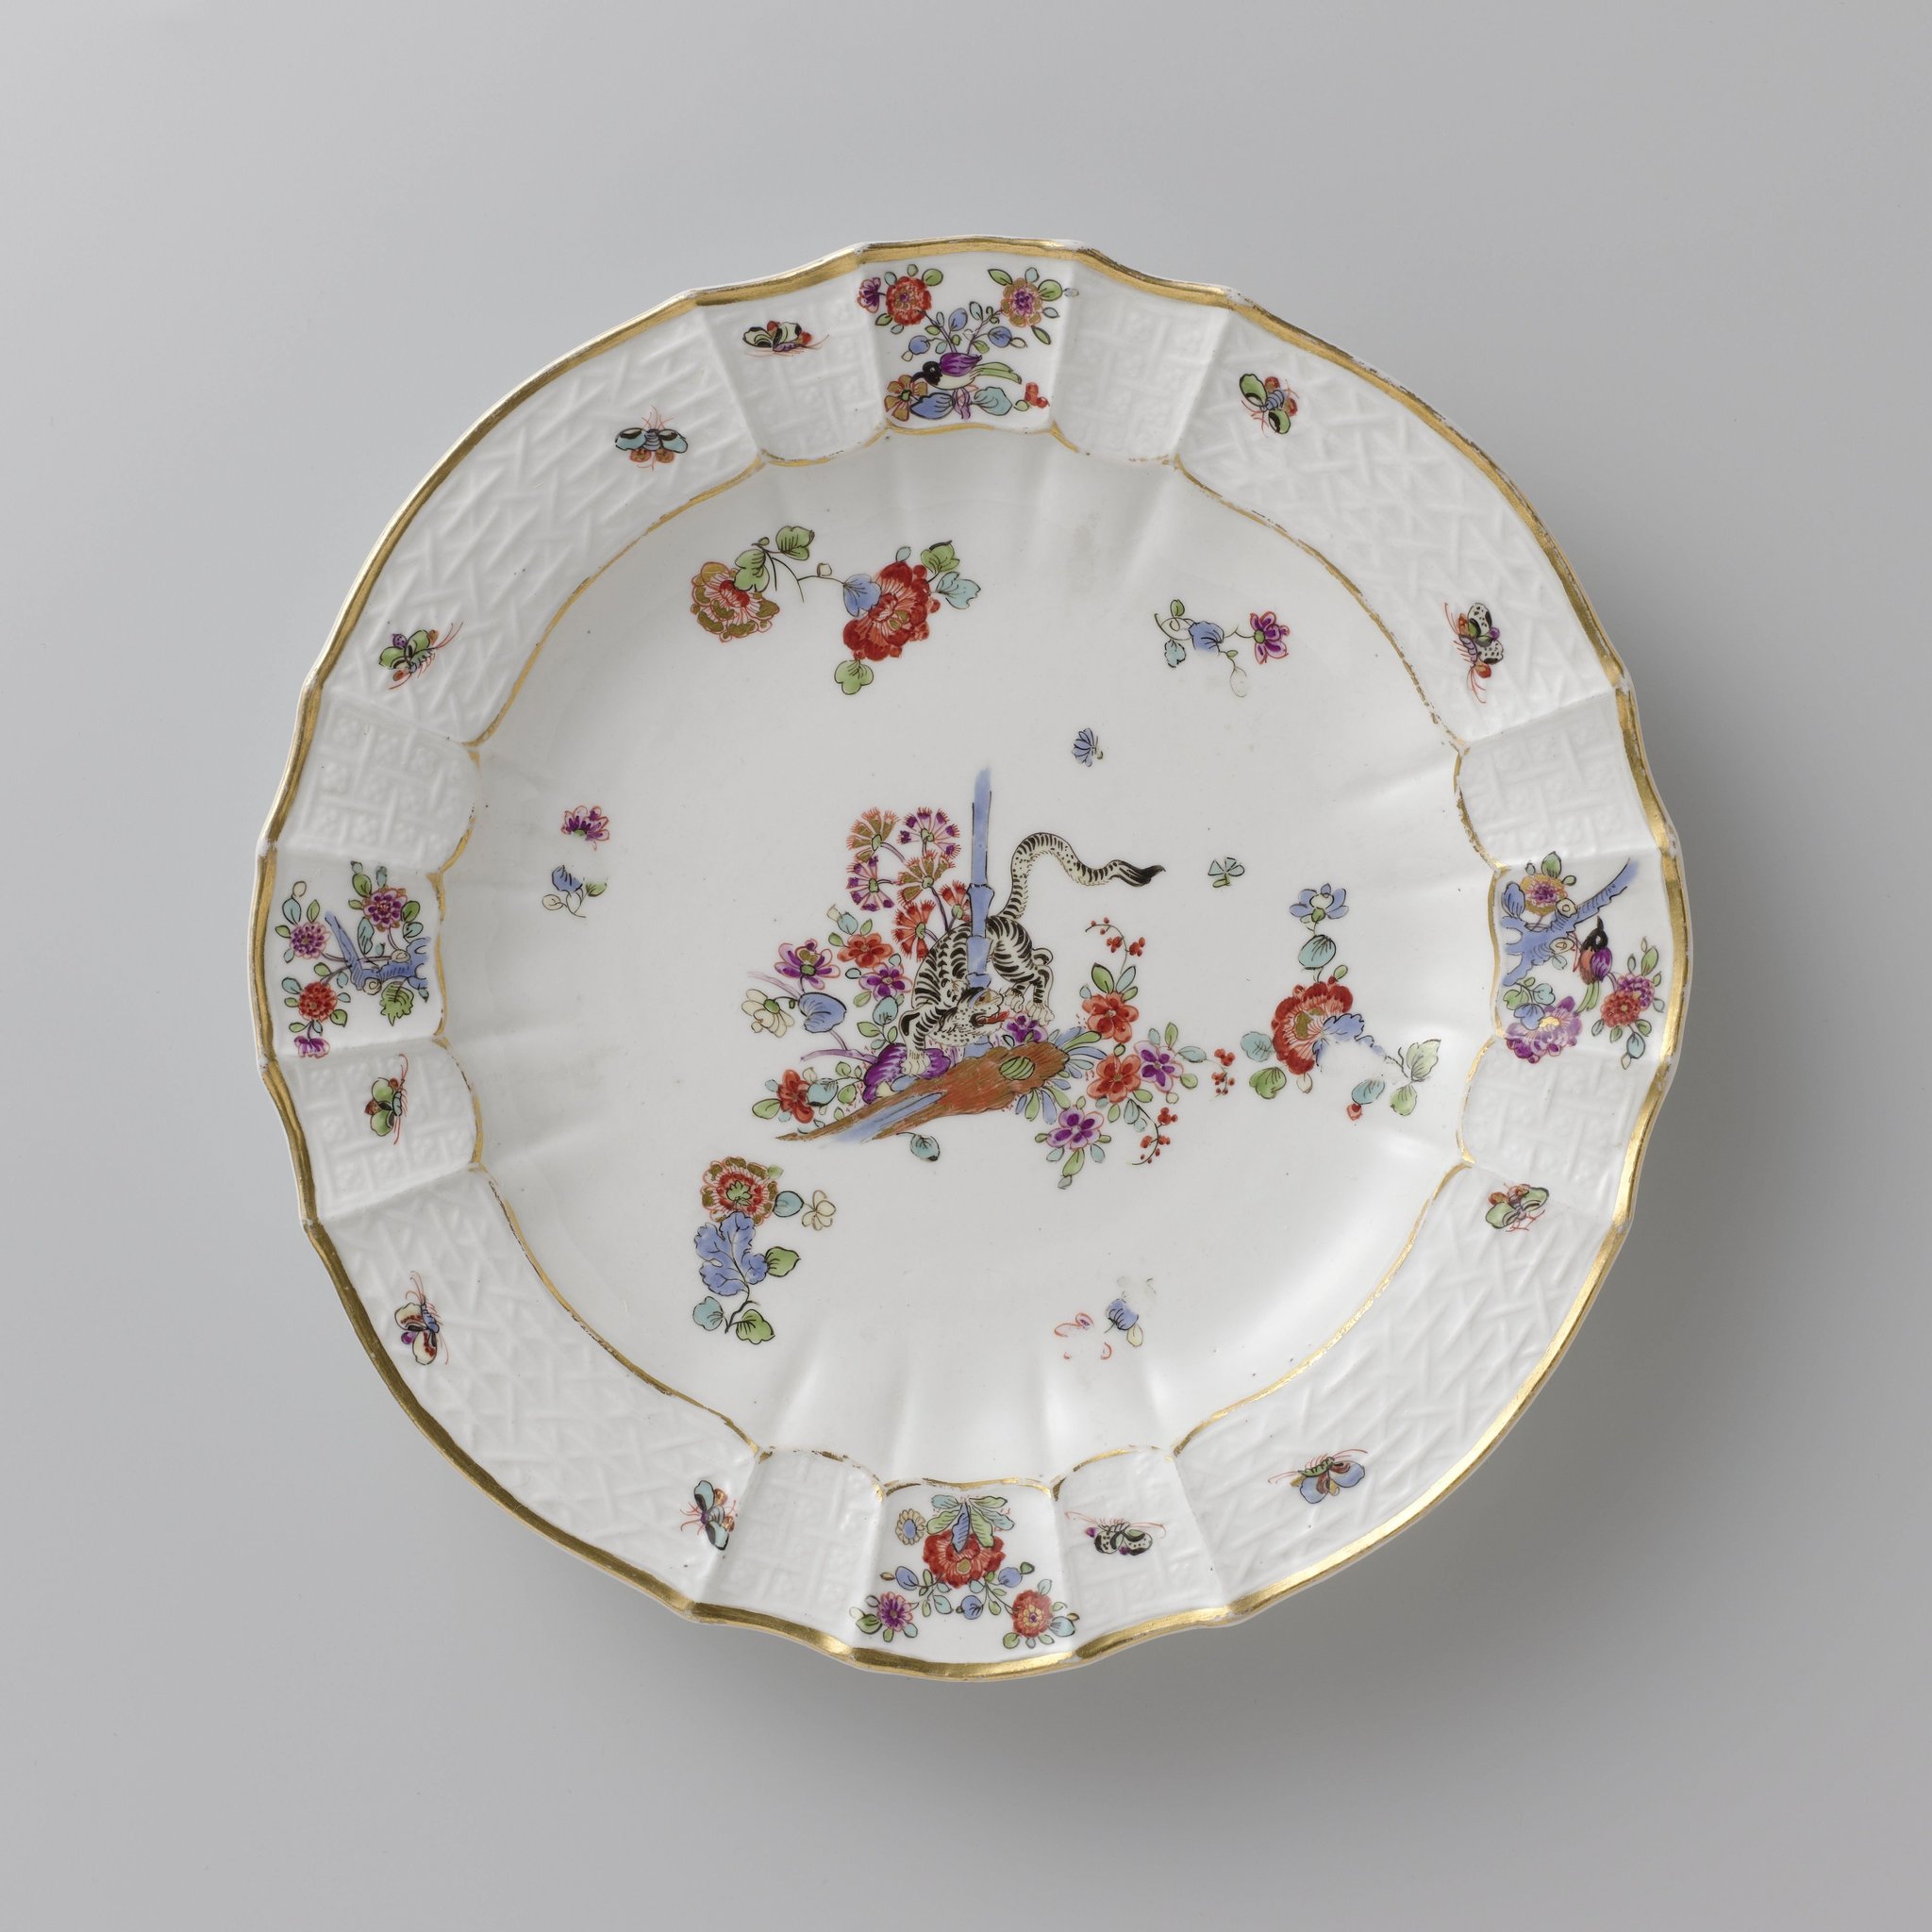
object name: plate dish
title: Rond bord, veelkleurig beschilderd met een Kakiemon-decor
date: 1740-1745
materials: porcelain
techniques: painted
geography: meissen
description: Rond bord van beschilderd porselein. Het bord is geribd en heeft een geschulpte rand. Het bord is beschilderd met een tijger die om een blauwe bamboestengel tussen bloemen is gedraaid, gestrooide Indianische Blumen, vlinders en takken waarop vogels. De rand is versierd met het 'Altbrandenstein'-patroon. Het bord is gemerkt.